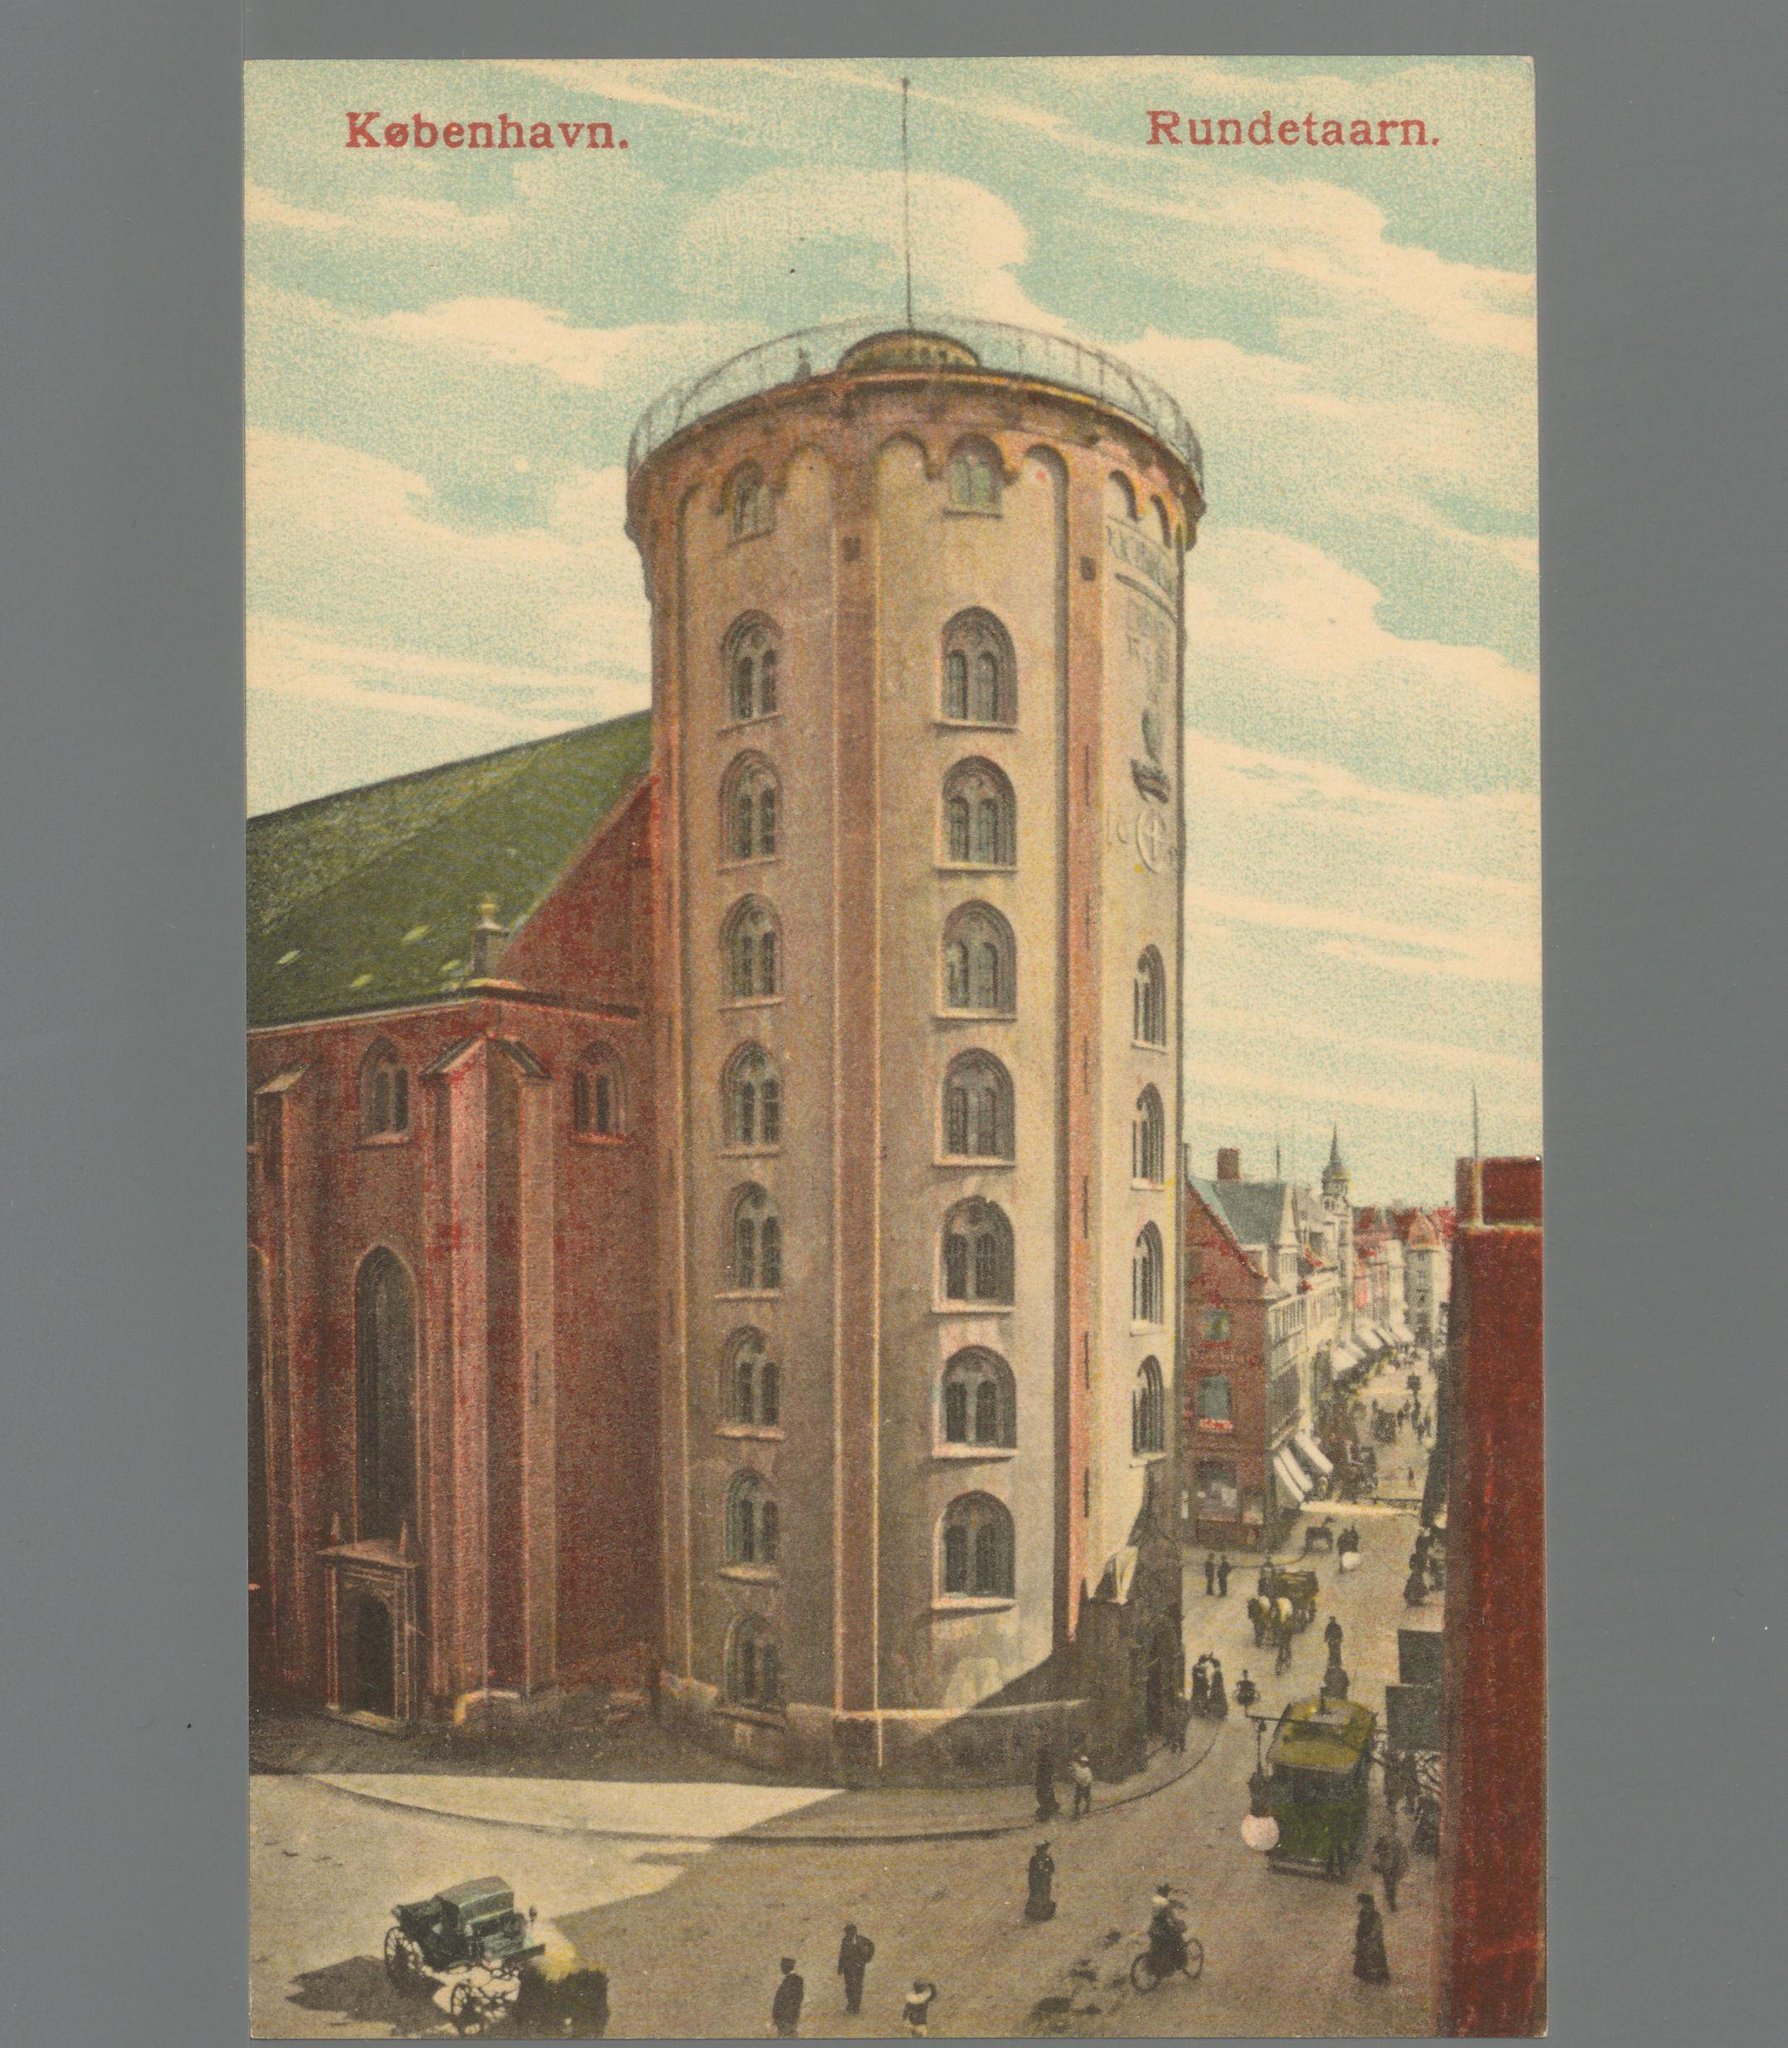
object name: photomechanical print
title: København. Rundetaarn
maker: Anonymous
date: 1906-1920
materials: cardboard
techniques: photograph, lithograph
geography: copenhagen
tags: tower, clock tower ~ monumental adornment, city-view, and landscape with man-made constructions (+ city(-scape) with figures, staffage), copenhagen (city)